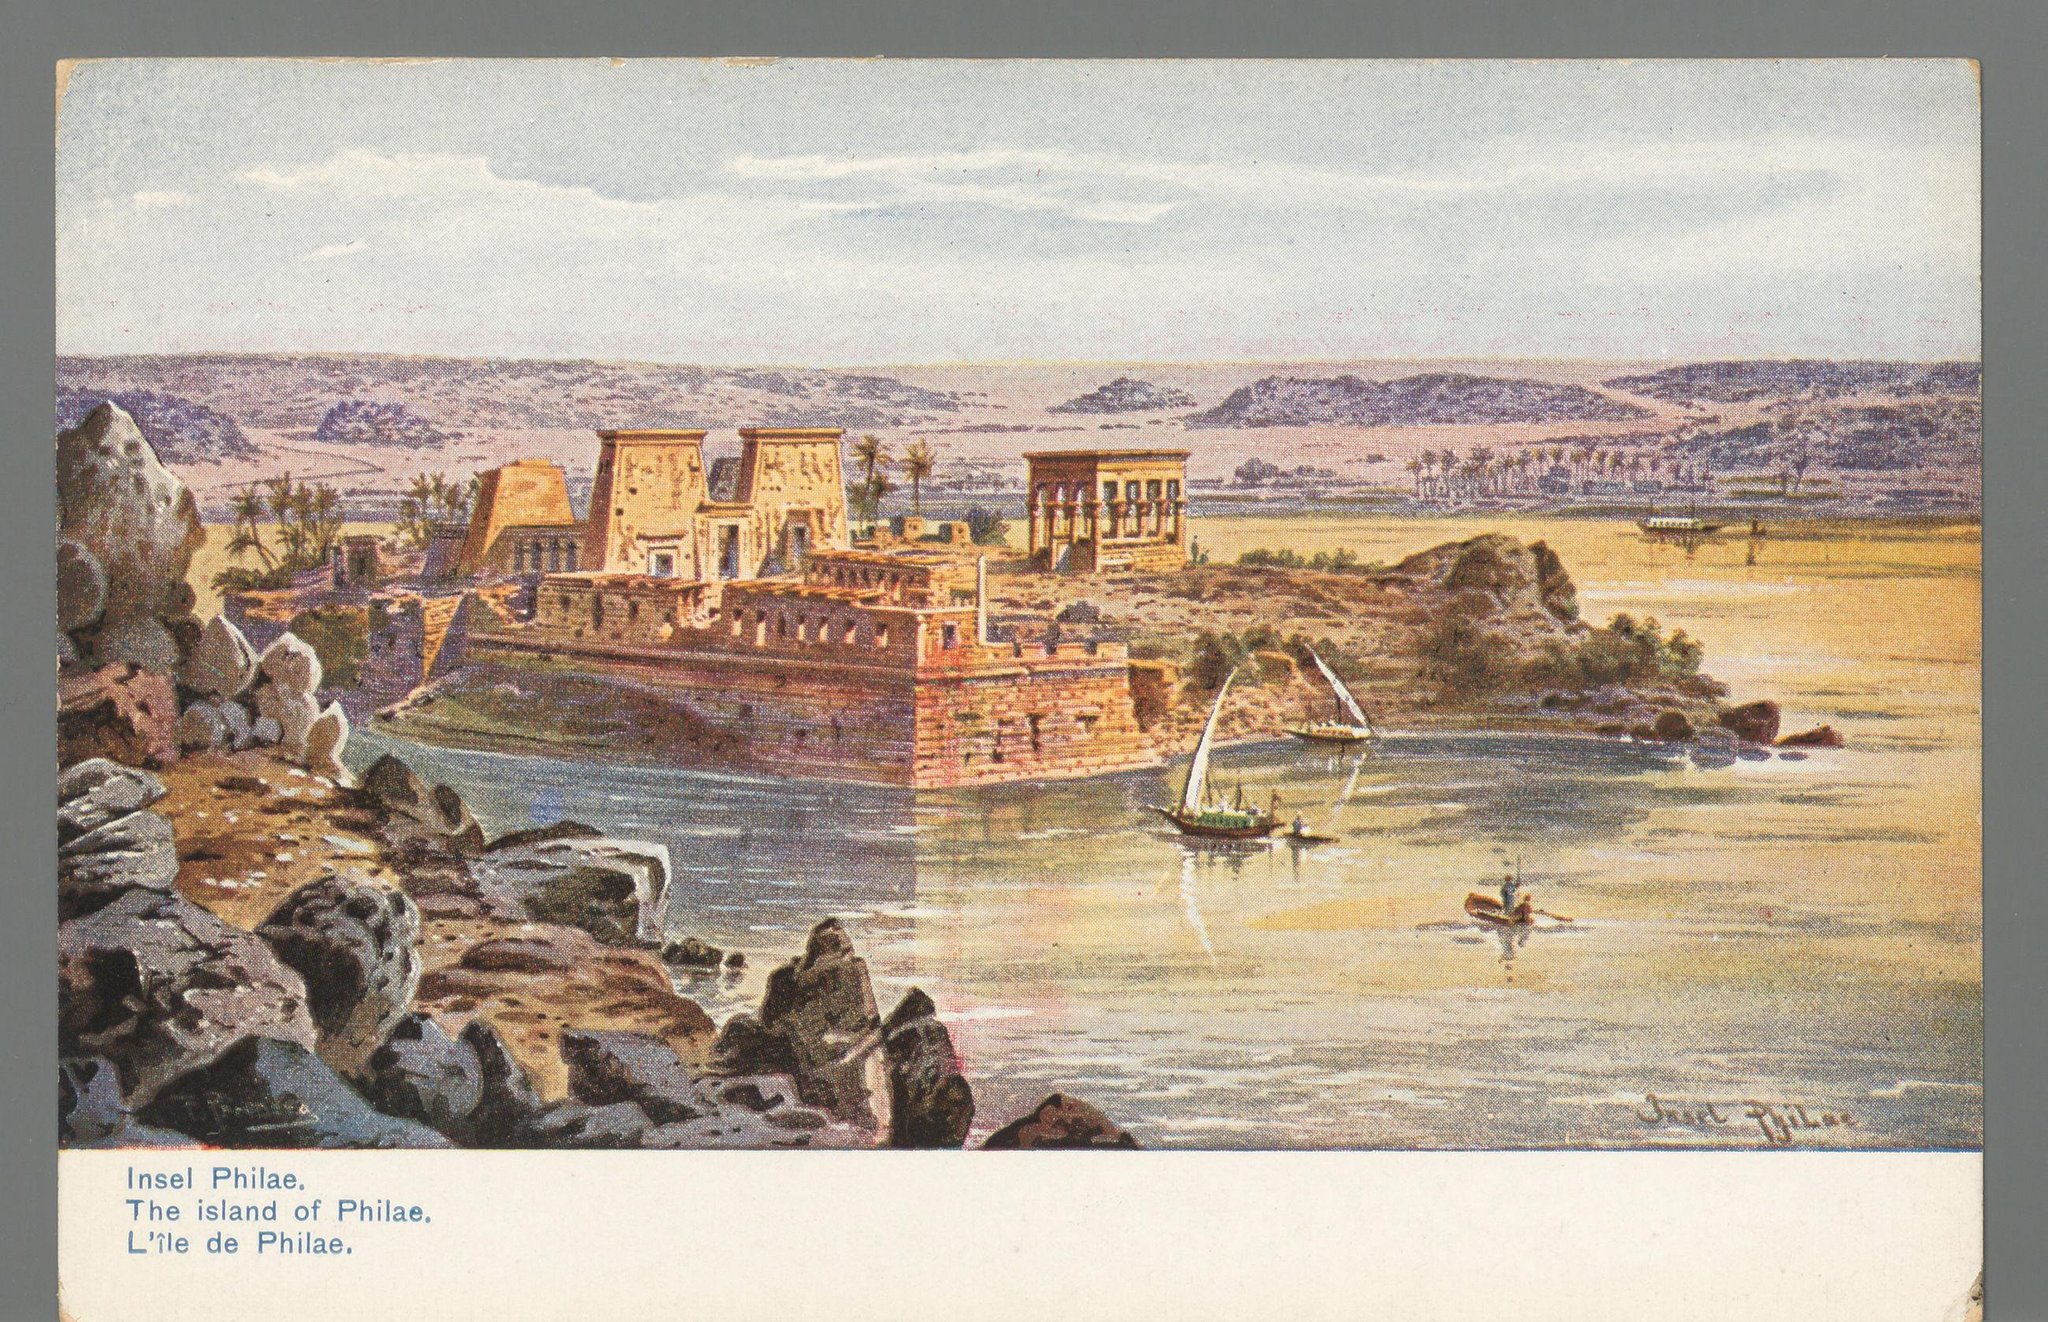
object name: reproduction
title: Insel Philae / The island of Philae / L'île de Philae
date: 1907-1930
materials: cardboard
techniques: color autotype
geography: germany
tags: island, temple, shrine ~ egyptian religion, river